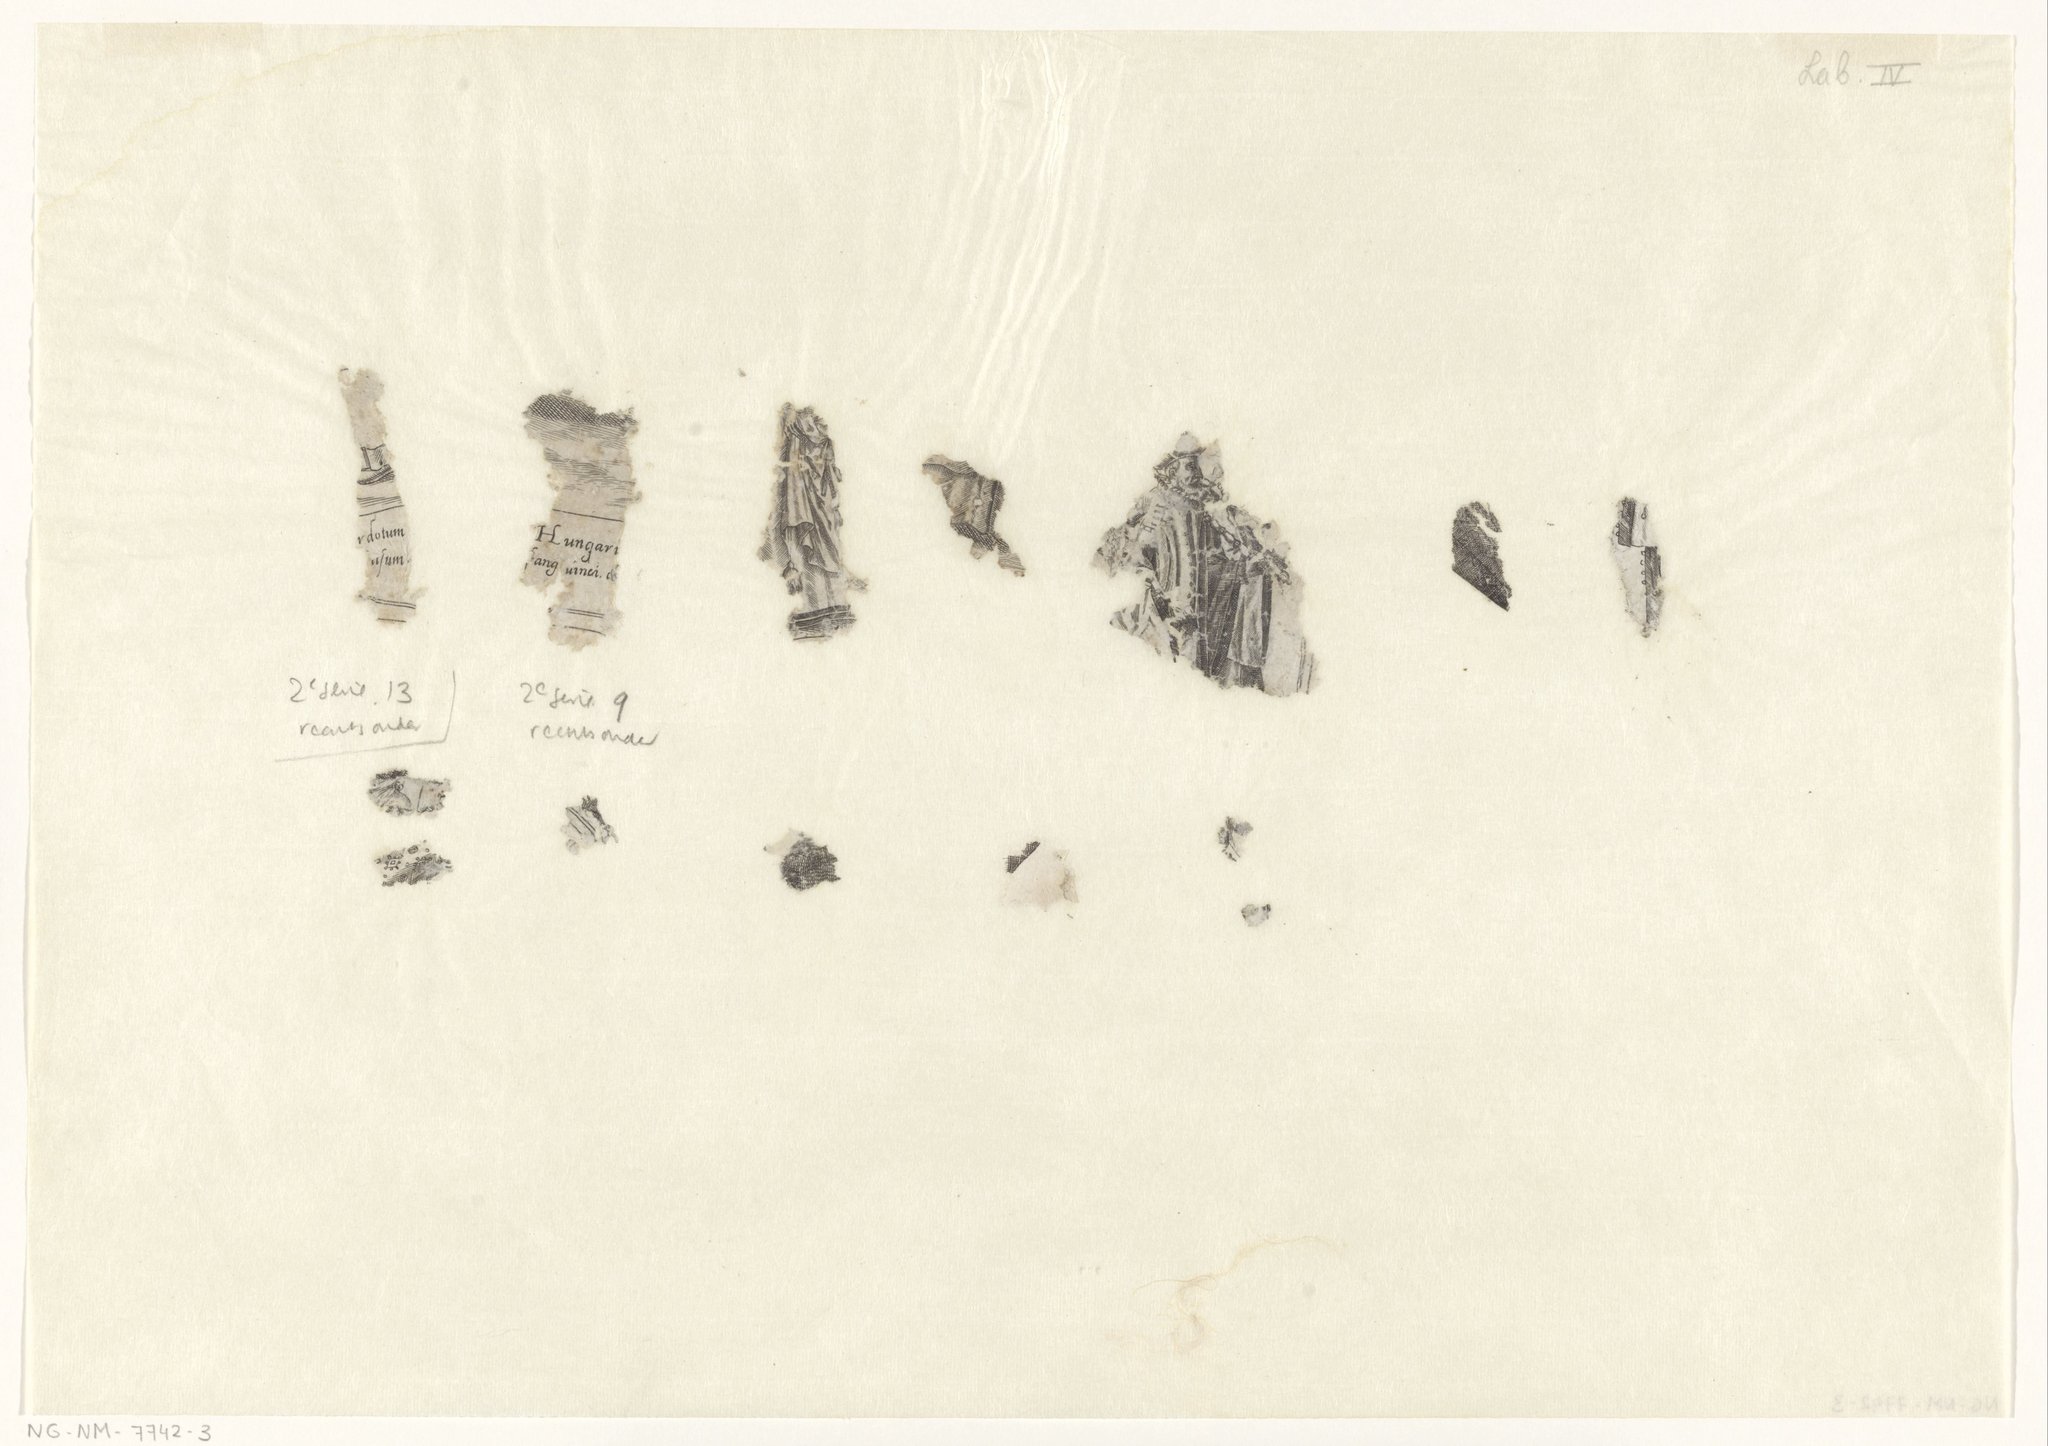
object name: costume print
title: Omnium pene Europae, Asiae, Aphricae atque Americae gentium habitus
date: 1581-1596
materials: paper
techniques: engraving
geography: cologne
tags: clothes, costume (+ women's clothes), clothes, costume (+ men's clothes)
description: De prenten in de Nova Zembla collectie zijn tijdens een expeditie van Willem Barendsz en Jacob van Heemskerk in 1596-1597 noodgedwongen in het winterkamp, het ‘Behouden Huis’, op het eiland achtergelaten. De prenten waren in één of meerdere stapels als handelswaar meegenomen vanuit Amsterdam. Bijna drie eeuwen later, in 1871, keerde de Noor Elling Carlsen terug naar Nova Zembla en vond daar de restanten van het ‘Behouden Huis, inclusief een groot deel van de inventaris. Een deel van de prenten, in de vorm van aaneengekoekte kluiten, werd toen ook teruggevonden. De papierkluiten waren soms op meerdere plekken gebroken. Tussen 1975-1979 zijn de prenten van elkaar gescheiden. Dit leverde in totaal ca. 1000 fragmenten van ca. 400 afdrukken van ca. 150 verschillende prenten op. Voor zover mogelijk zijn de fragmenten samengevoegd en zijn de prenten gereconstrueerd.